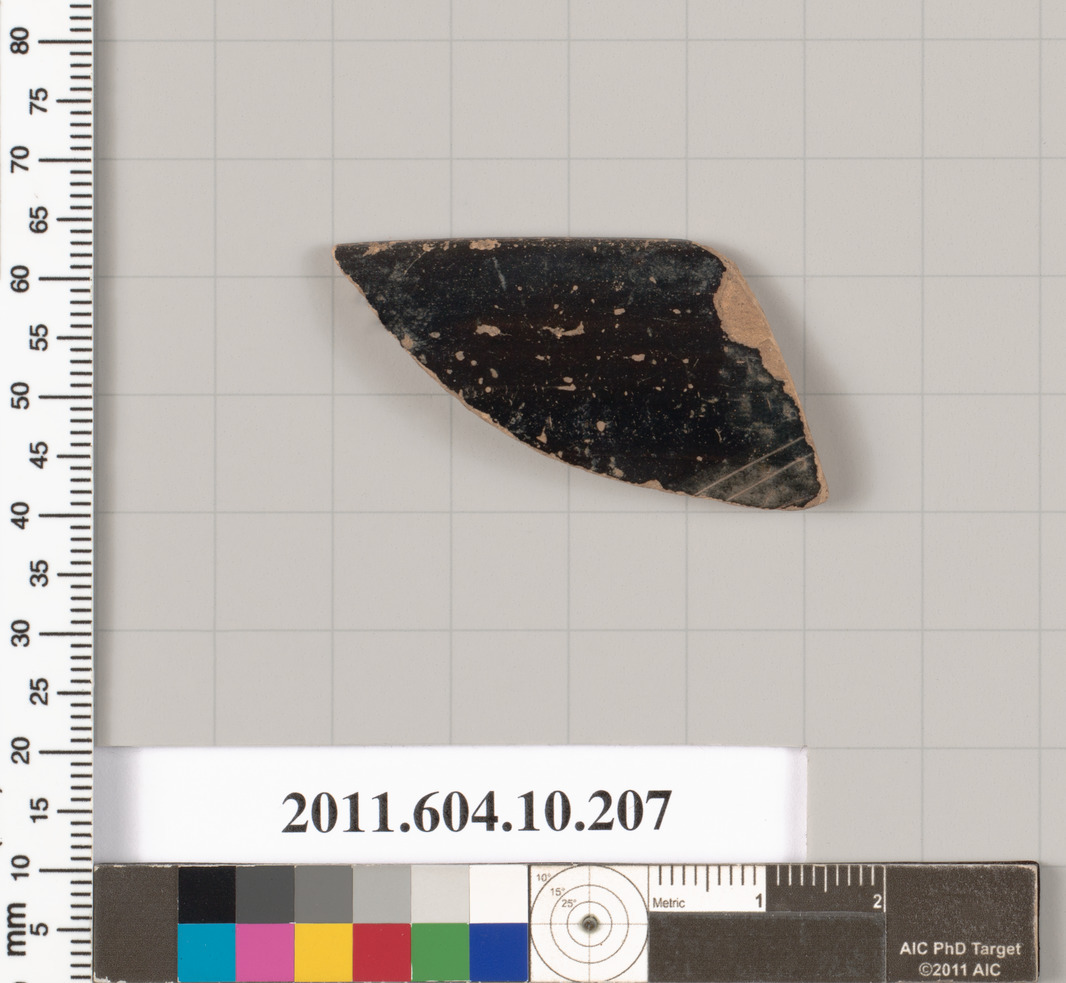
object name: kylix fragment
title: Terracotta rim fragment of a kylix (drinking cup)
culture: etruscan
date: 600-501 BCE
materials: terracotta